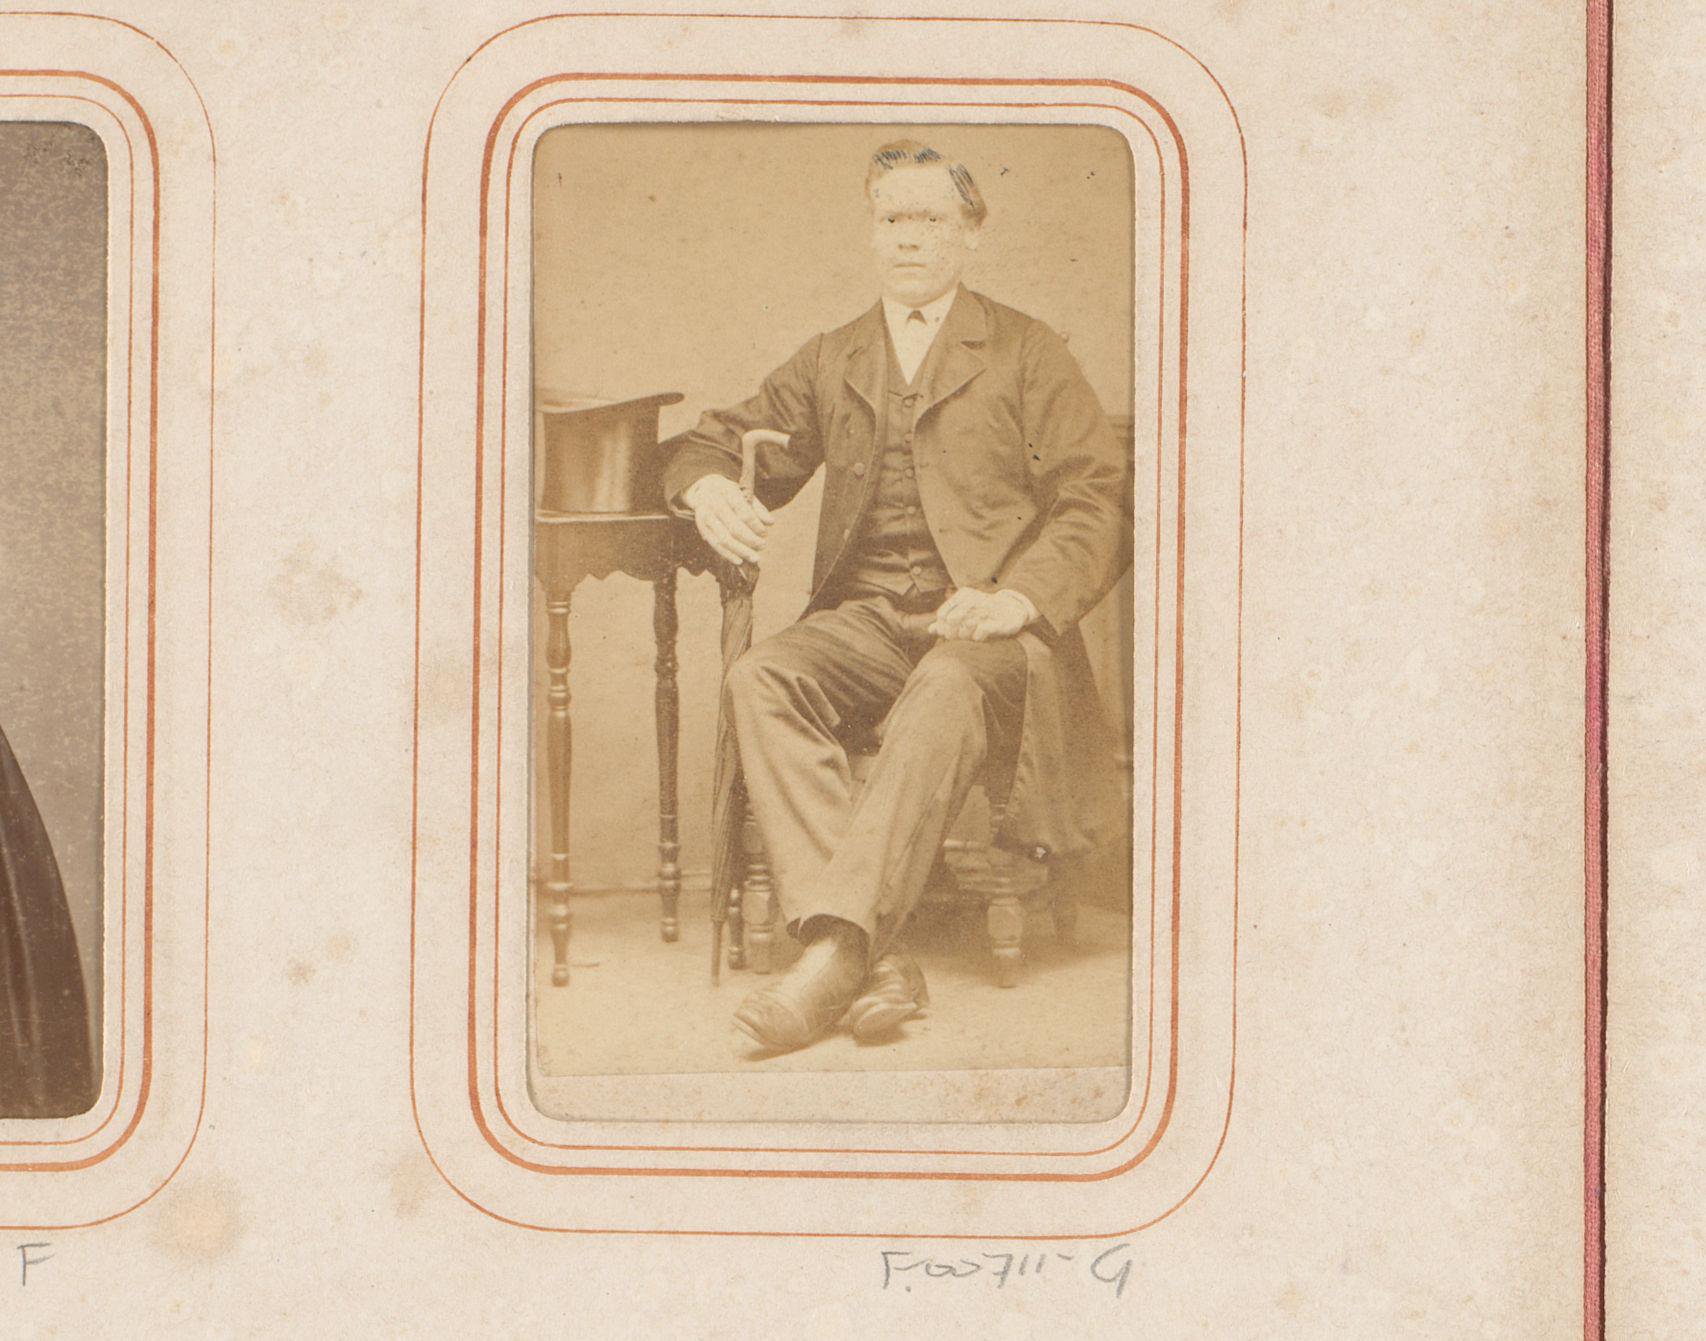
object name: album leaf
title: Portret van een zittende man met een hoge hoed en paraplu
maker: hironimus fraenkel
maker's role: fotograaf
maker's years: 1811-1887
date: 1867-1887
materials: cardboard, photographic support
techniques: albumen print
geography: amsterdam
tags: historical persons, head-gear: hat, umbrella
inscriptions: inscription: ‘Photographisch Atelier/ H. Fraenkel & Söhne/ 2e, Utrechtsche Straat, Y320/ Amsterdam’